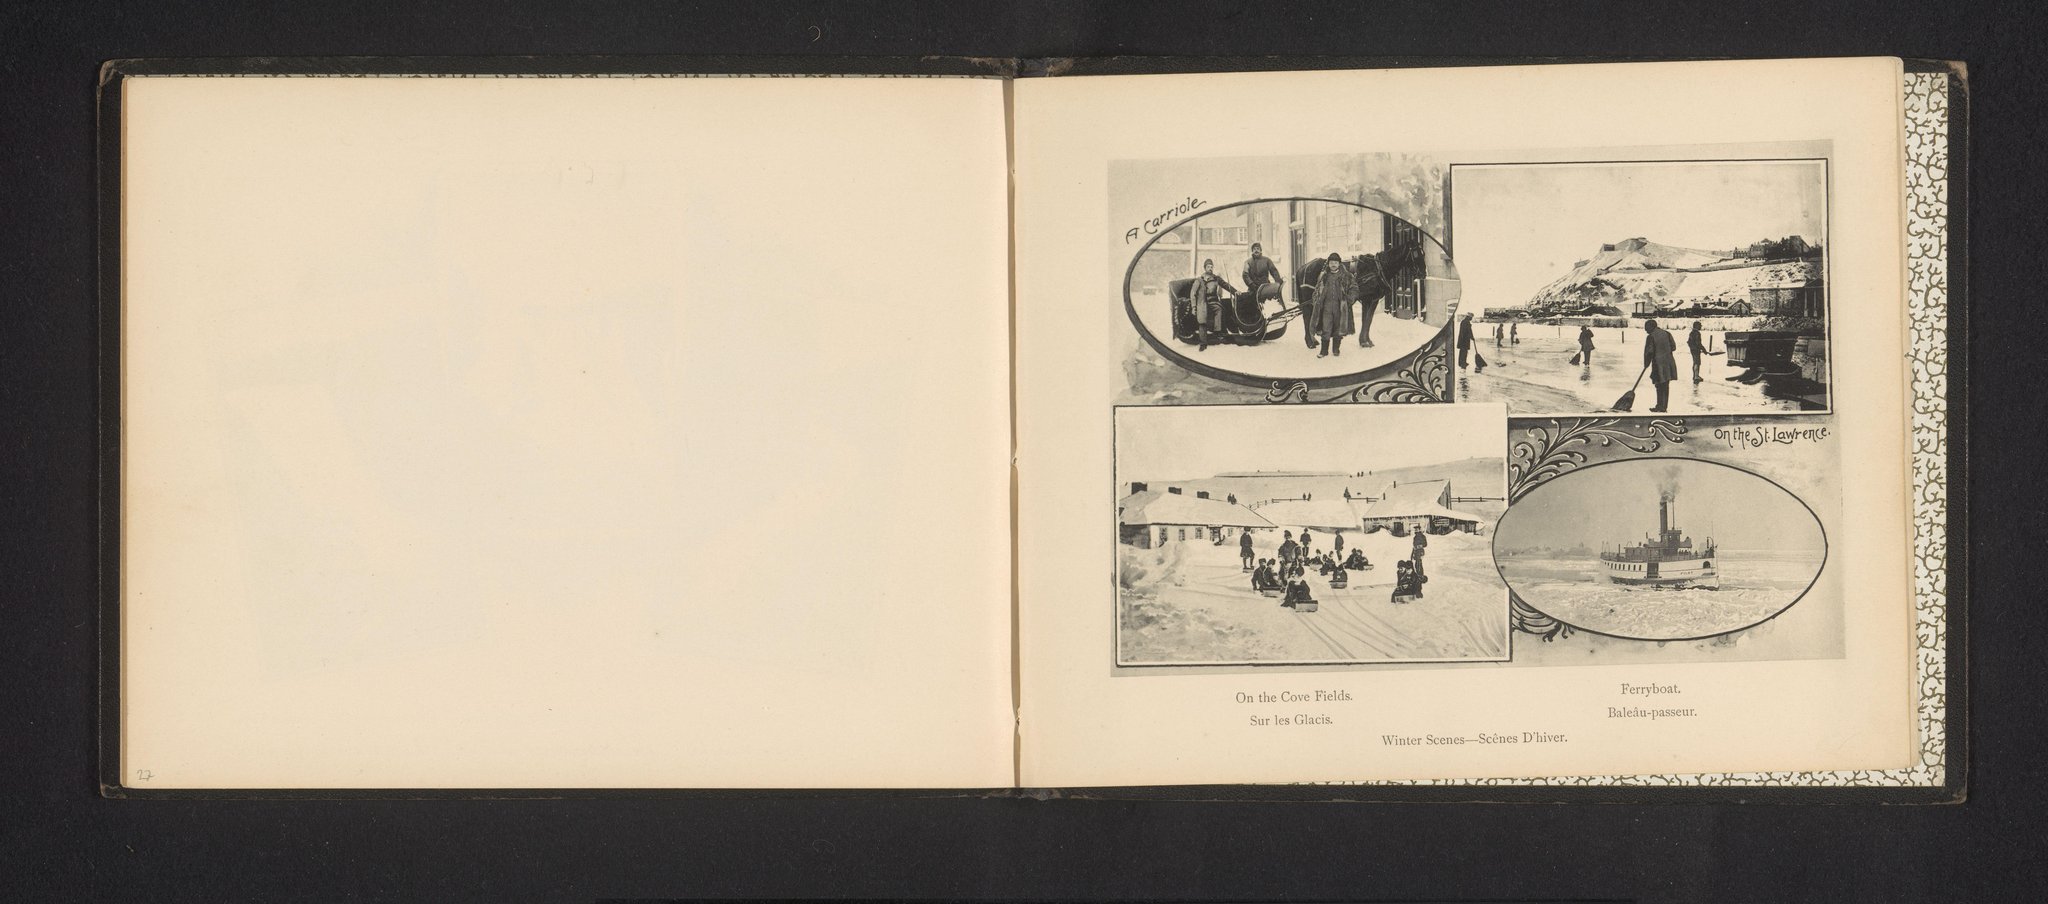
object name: photomechanical print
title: Winter Scene, Scênes D'hiver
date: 1889-1894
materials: paper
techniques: photograph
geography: quebec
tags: river, ferry, snow, sledge, sleigh (winter sports), québec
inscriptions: inscription: ‘On the Cove Fields/ Sur les Glacis/ Ferryboat/ Baleâu-passeur’